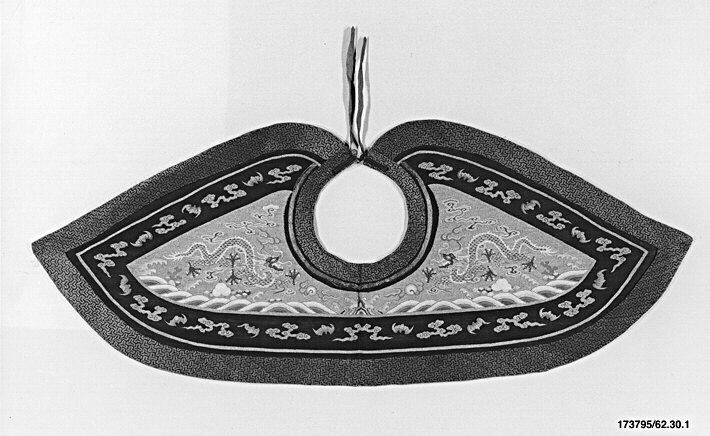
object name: collar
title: Zhaofu Collar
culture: chinese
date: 1701-1733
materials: gold leaf, metal thread, silk